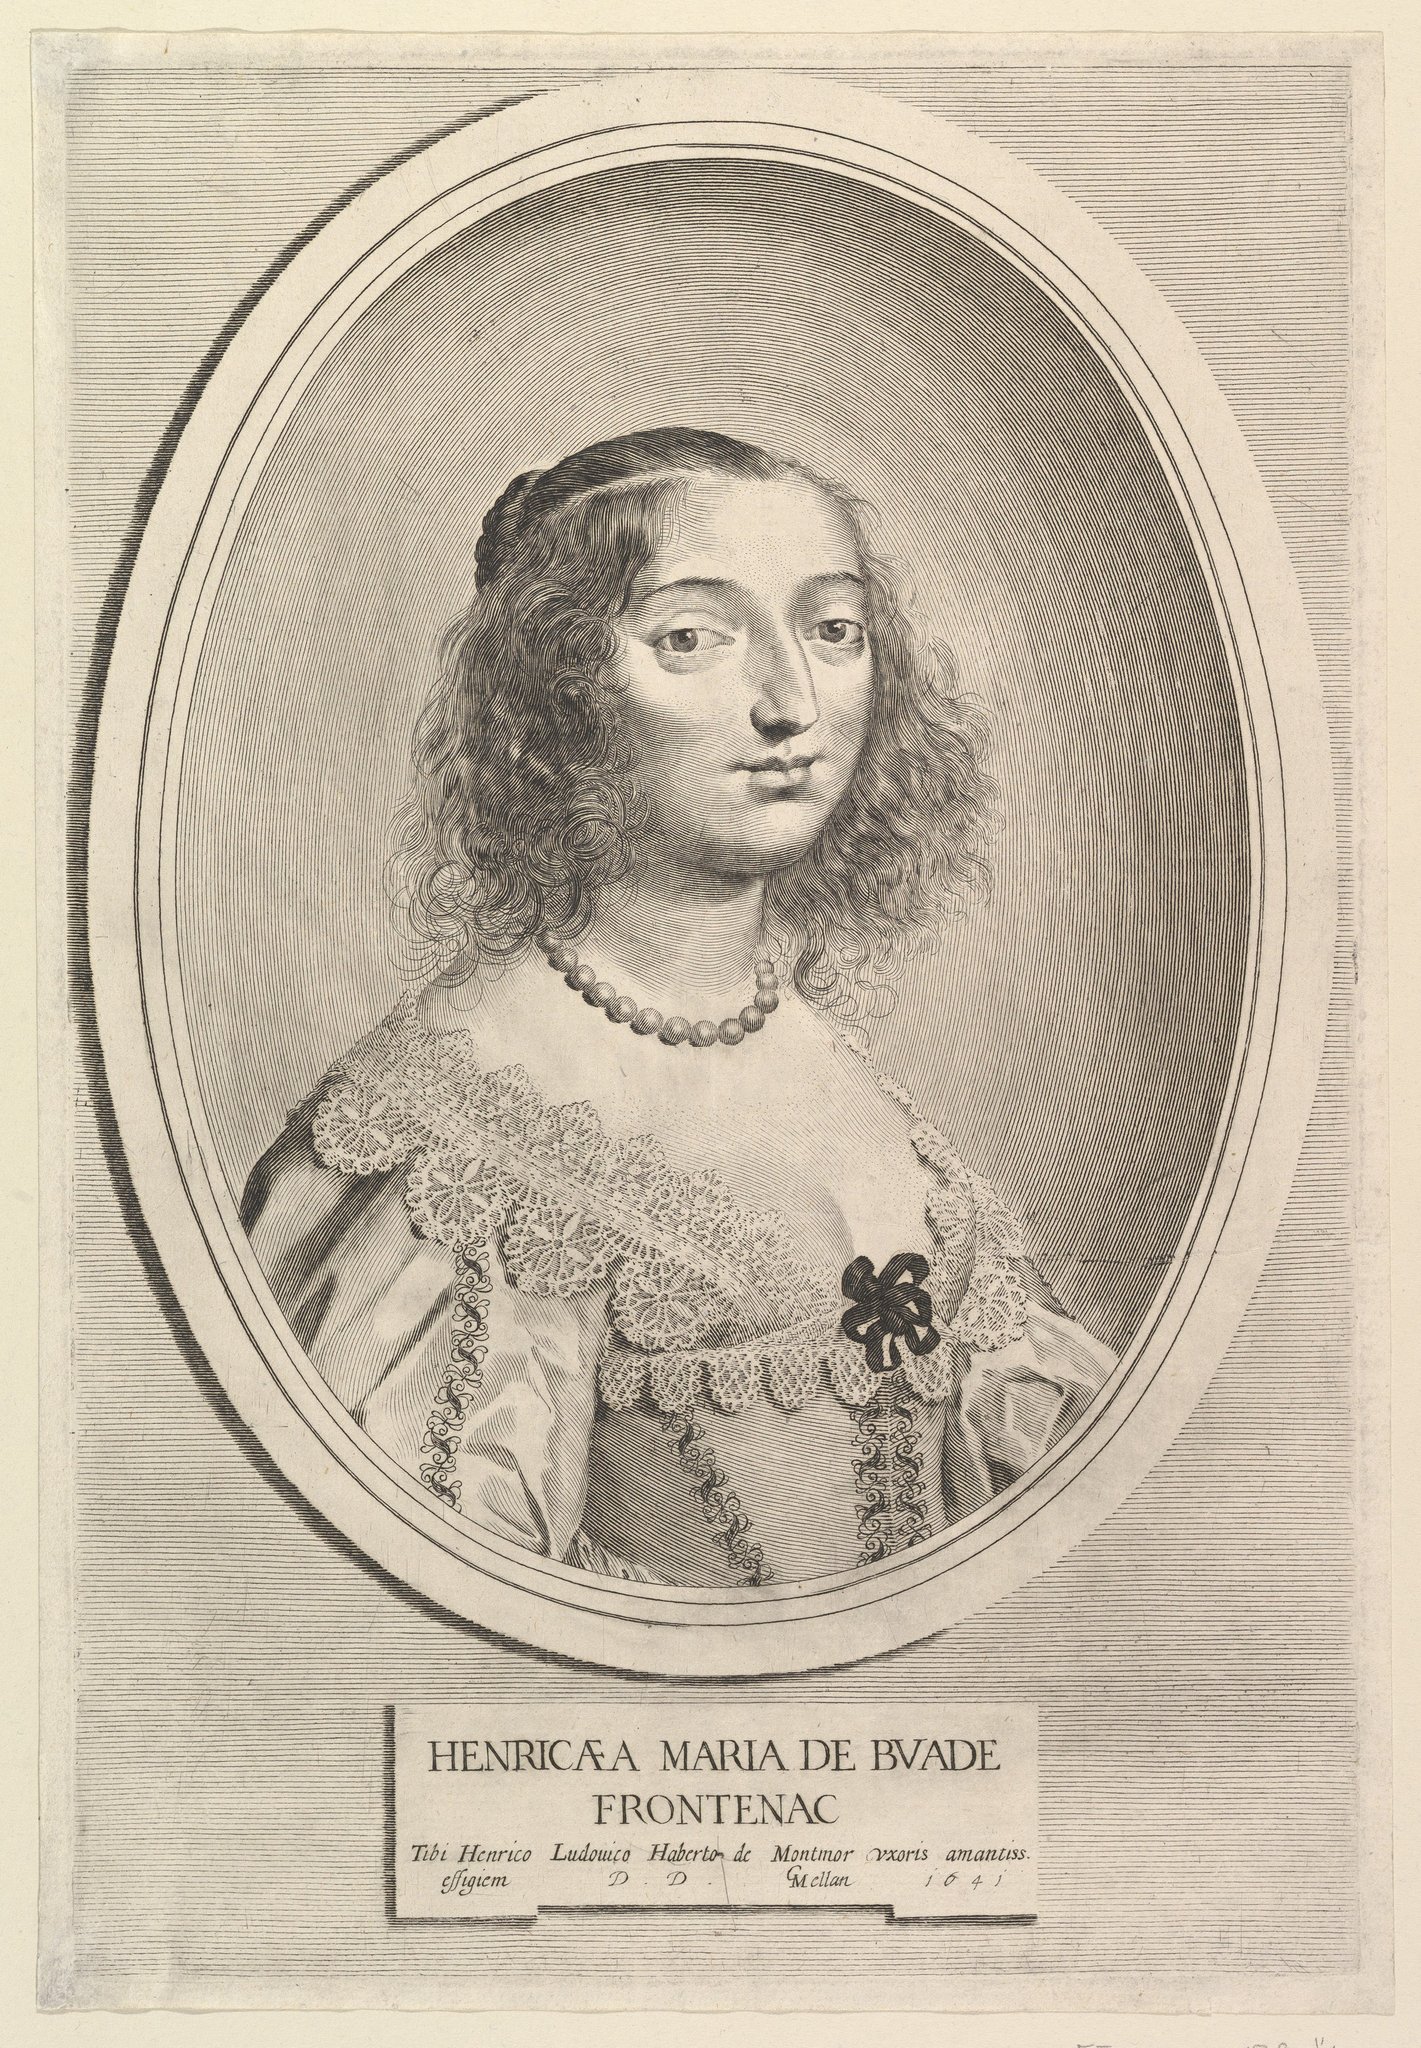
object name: print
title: Henriette-Marie de Buade-Frontenac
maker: claude mellan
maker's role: artist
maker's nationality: french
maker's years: 1598-1688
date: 1641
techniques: engraving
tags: portraits,women